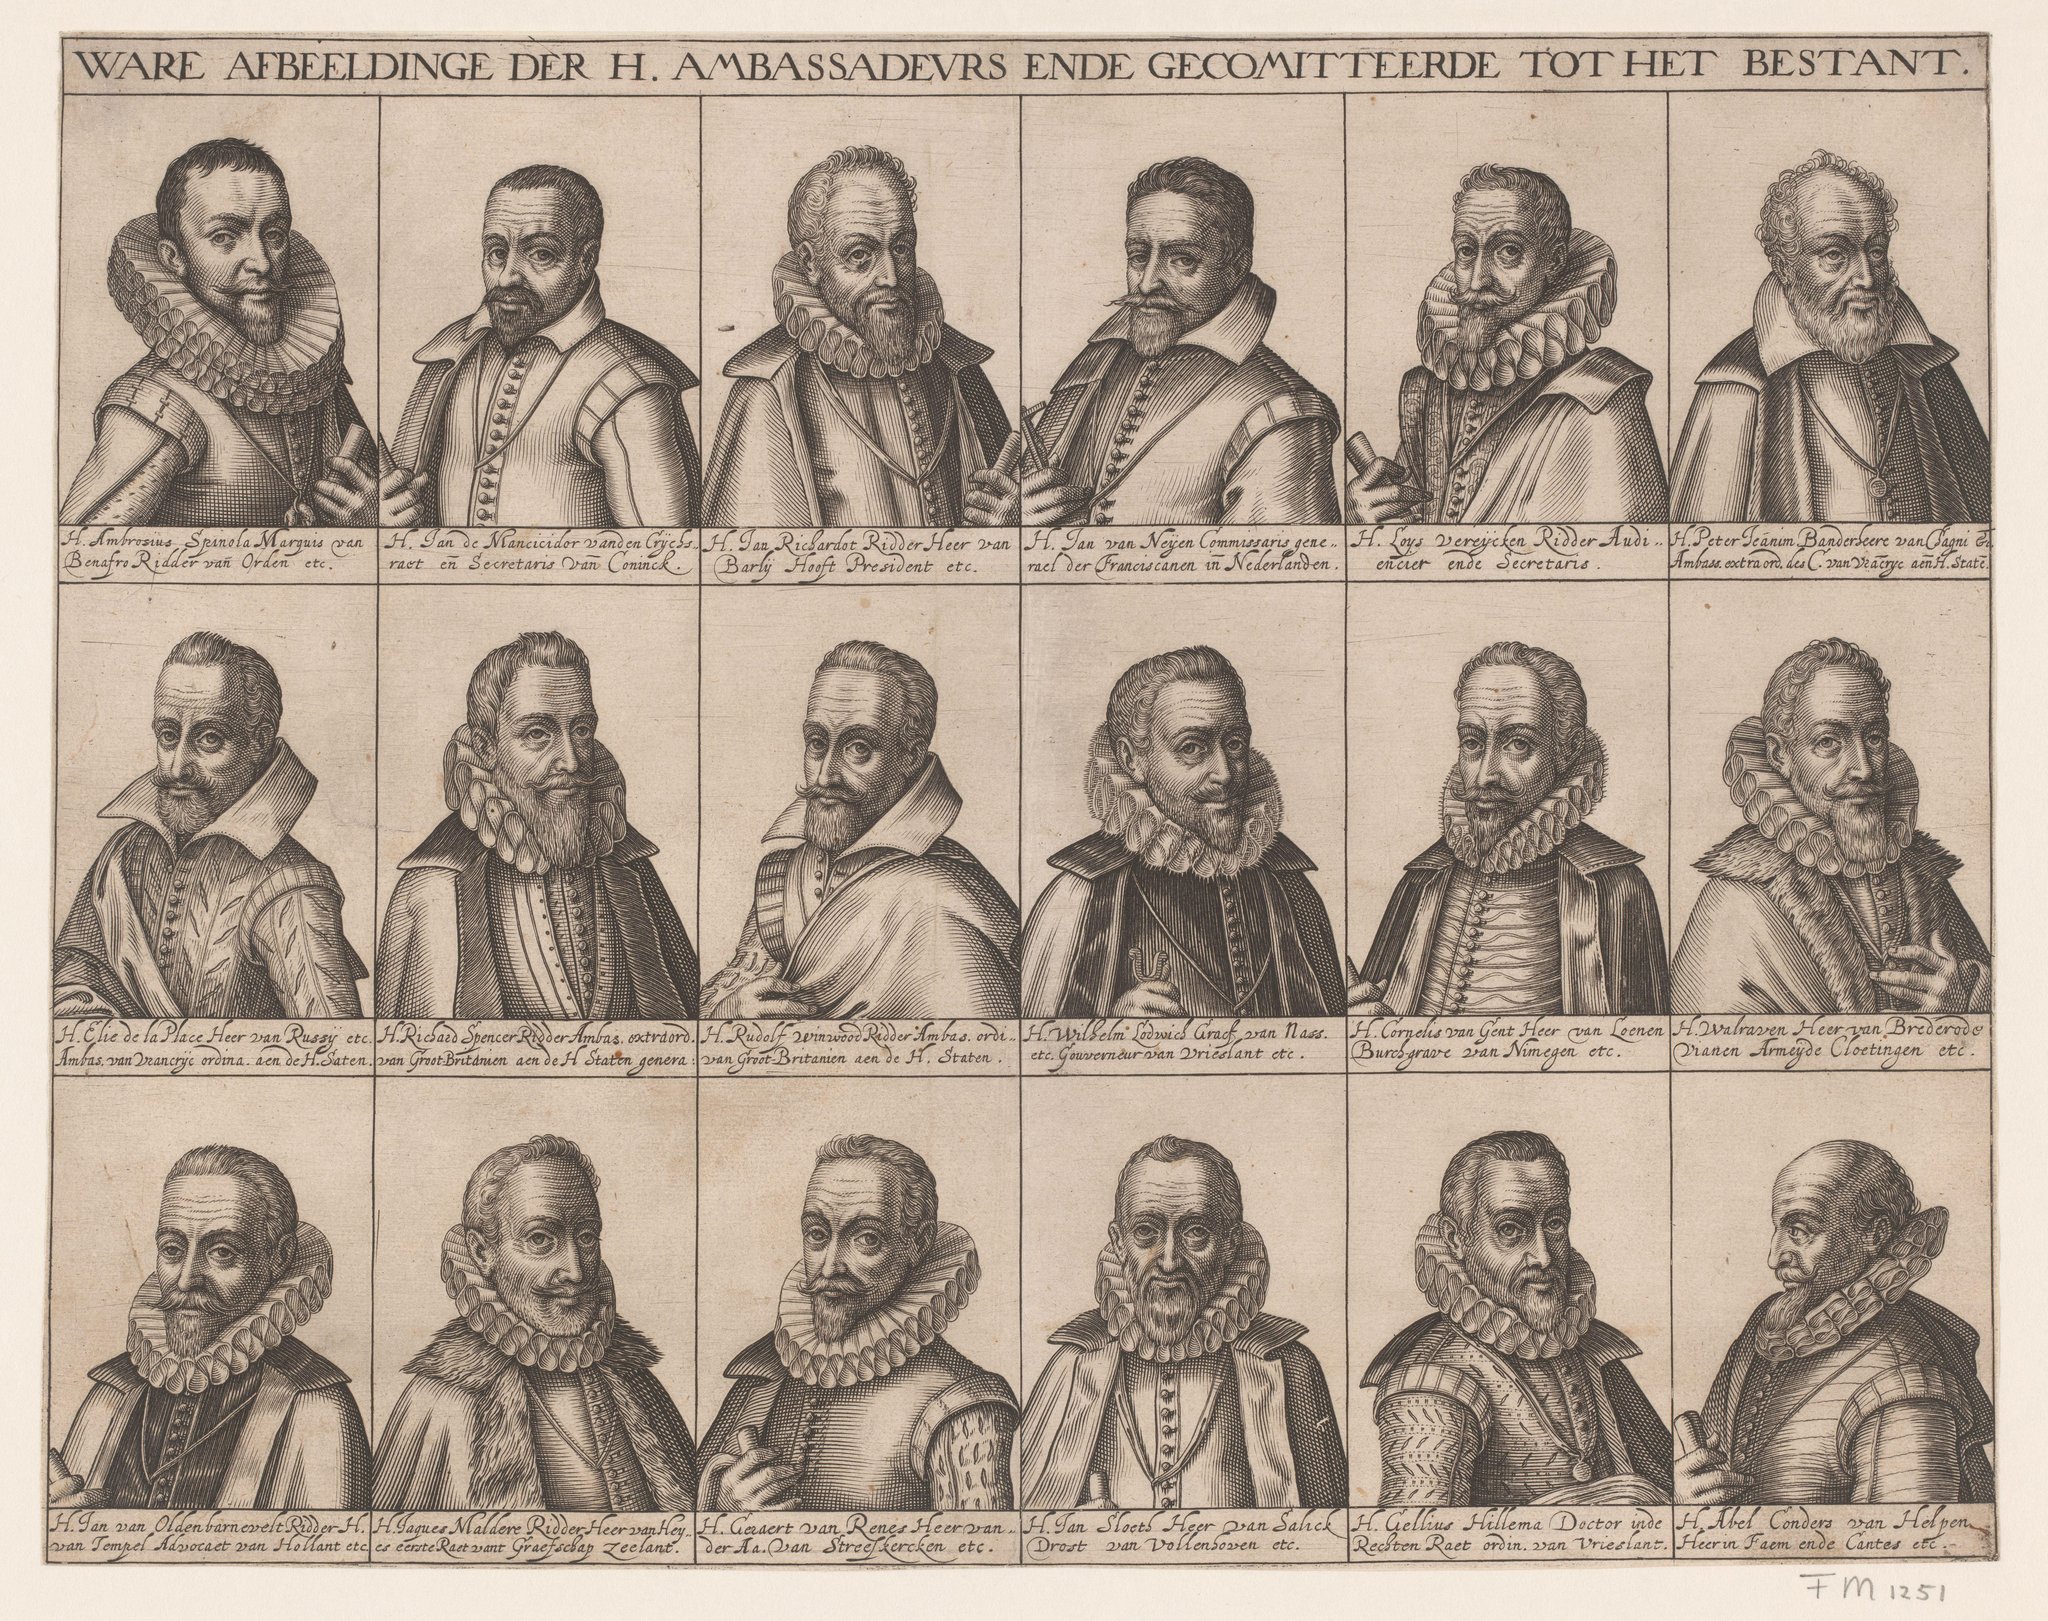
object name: print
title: Ware afbeelding der h. ambassadeurs ende gecomitteerde tot het bestant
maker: Anonymous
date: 1614-1616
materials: paper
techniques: engraving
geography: northern netherlands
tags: jacob van malderé, the hague, johan van oldenbarnevelt, willem lodewijk graaf van nassau-dillenburg, cornelis van gent, paris, peace negotiations, historical persons